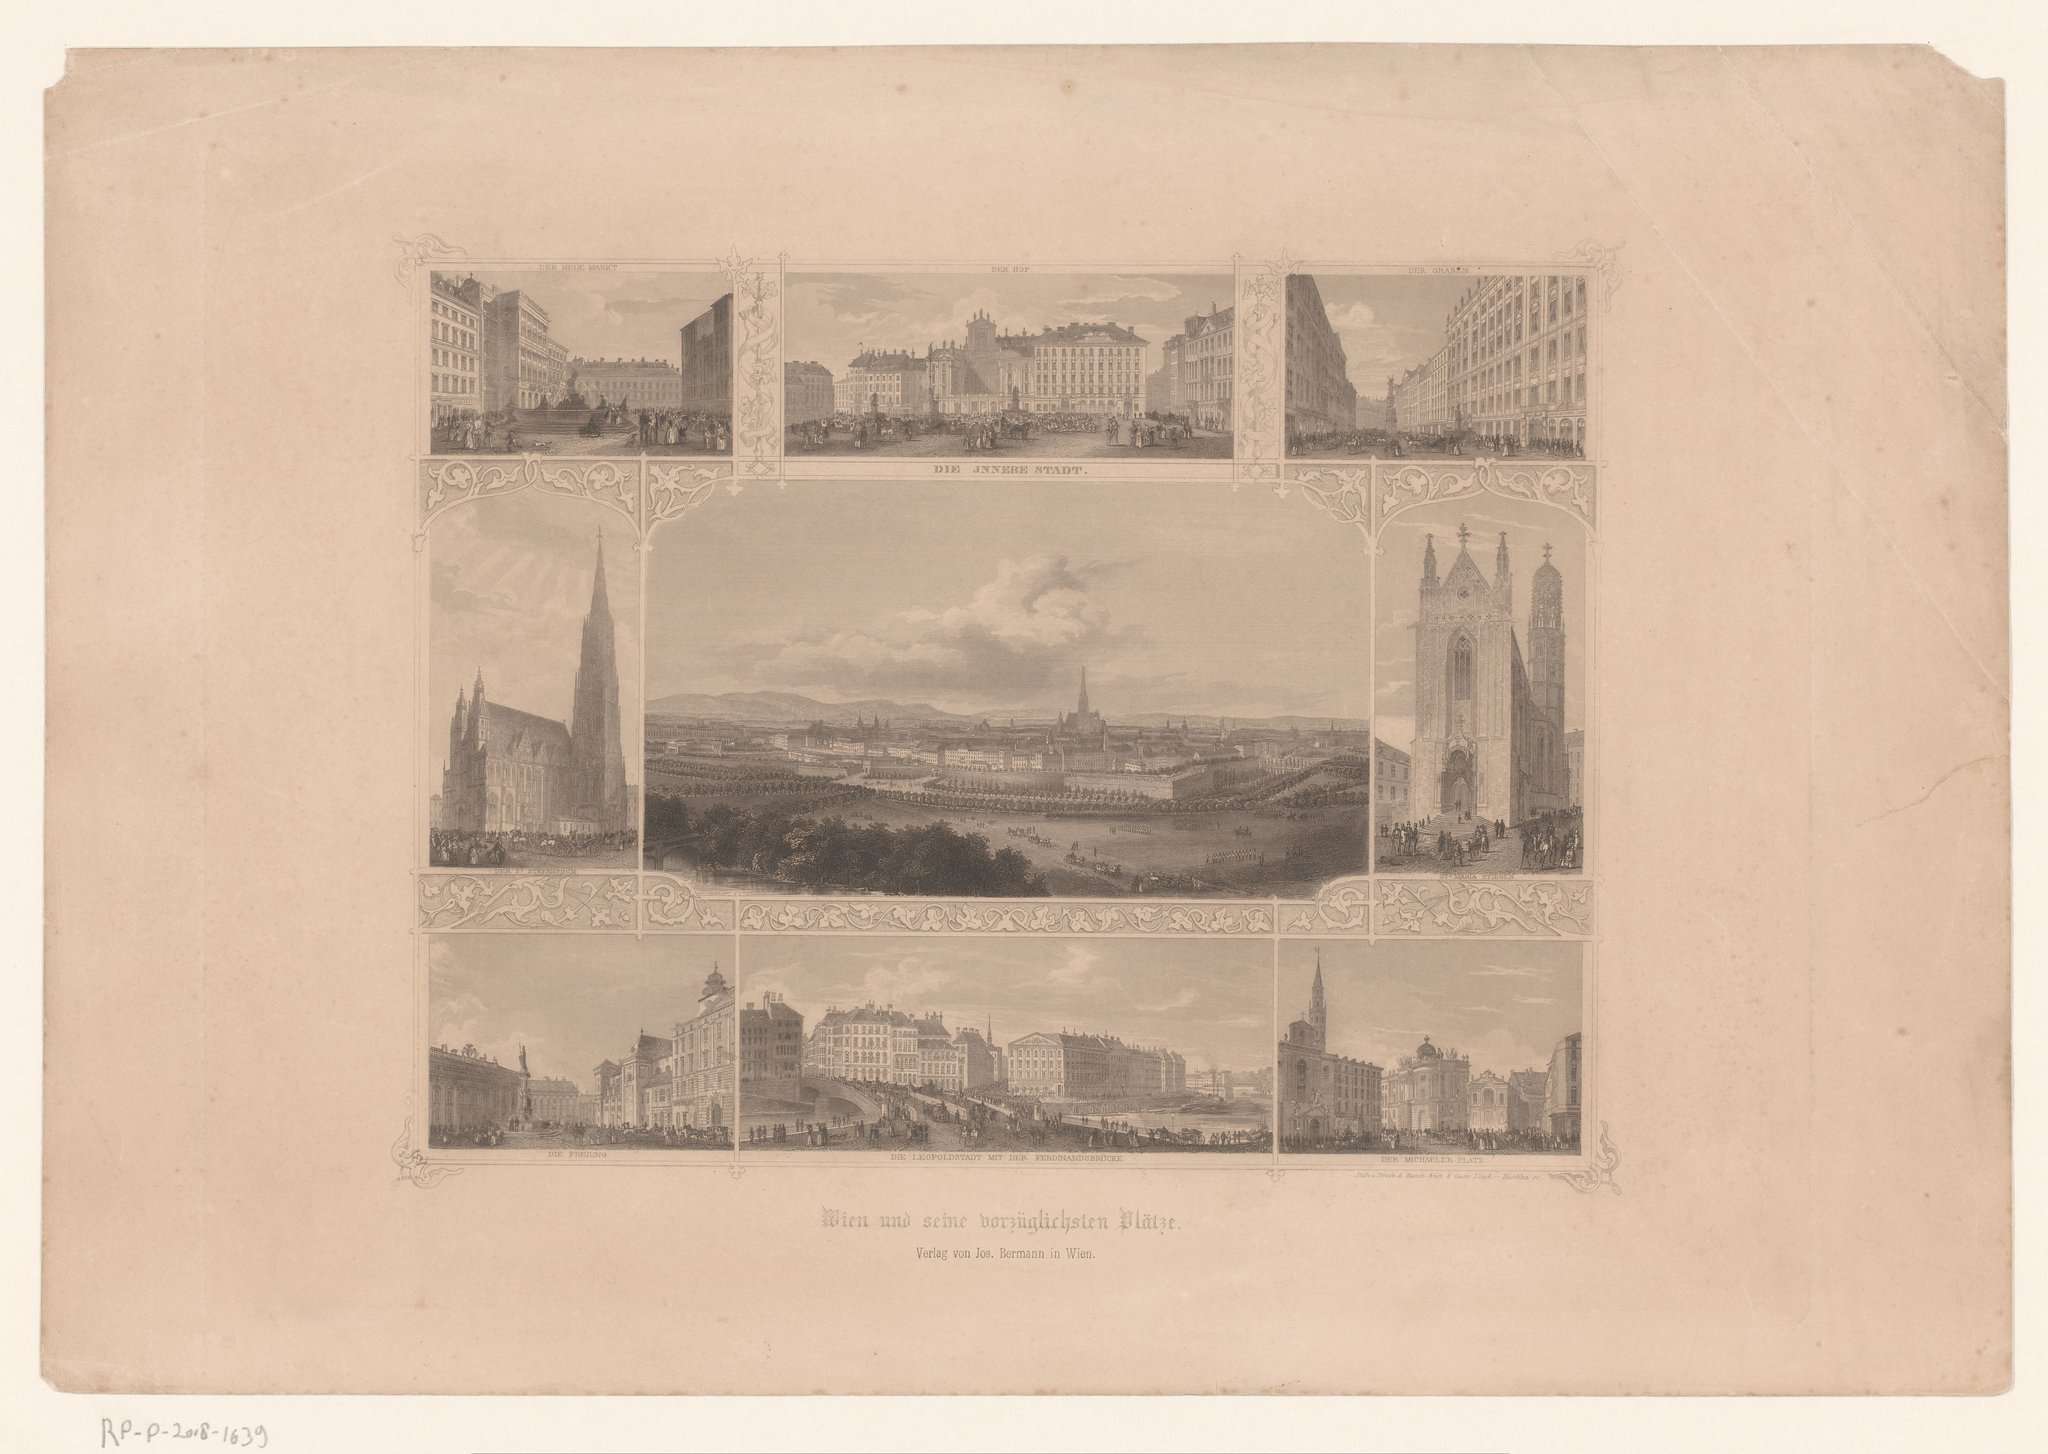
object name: print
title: Wien und seine vorzüglichsten Plätze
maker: reschka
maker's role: print maker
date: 1800-1899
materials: paper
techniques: engraving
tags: prospect of city, town panorama, silhouette of city, vienna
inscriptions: collector's mark: Lugt 2228